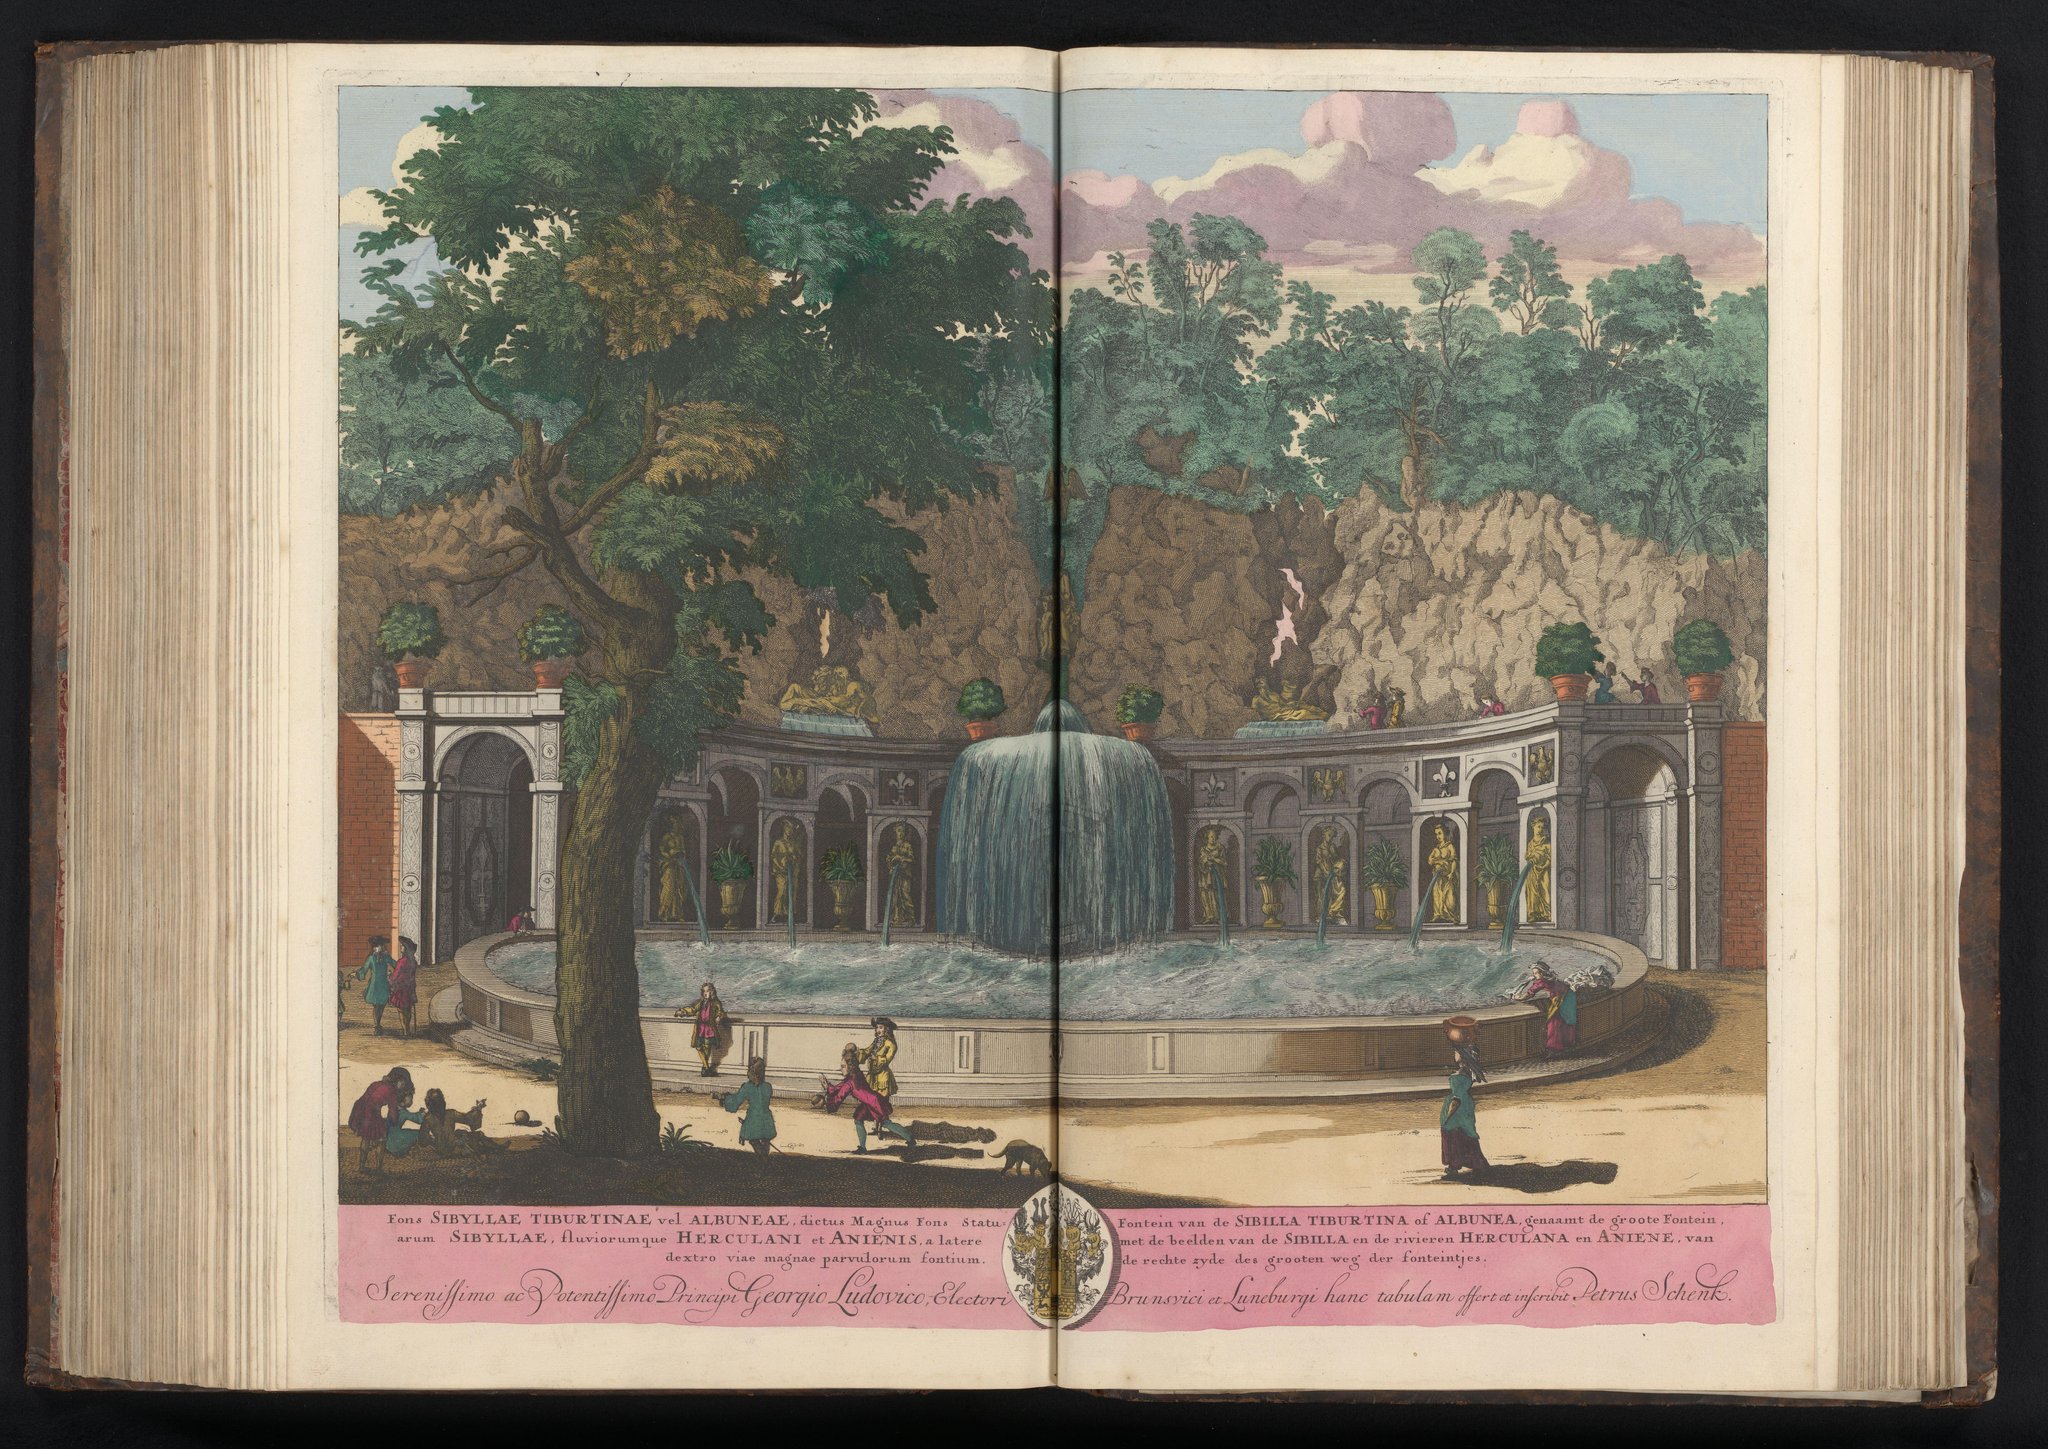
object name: print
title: Fons Sibyllae Tiburtinae vel albuneae, dictus Magnus Fons Statuarum Sibylla (...)/ Fontein van de Sibilla Tiburtina of Albunea, genaamt de groote Fontein (...)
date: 1670-1711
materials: paper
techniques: colour, etching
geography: the hague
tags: city-view, and landscape with man-made constructions, garden, nymphs (in general); 'ninfe in commune' (ripa), piece of sculpture, reproduction of a piece of sculpture, ornamental fountain, tivoli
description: Gezicht op de Fontein van de Tiburtijnse Sibille in de tuin van de Villa d'Este te Tivoli. Titel in het Latijn en in het Nederlands in de ondermarge. Prent maakt deel uit van een album.